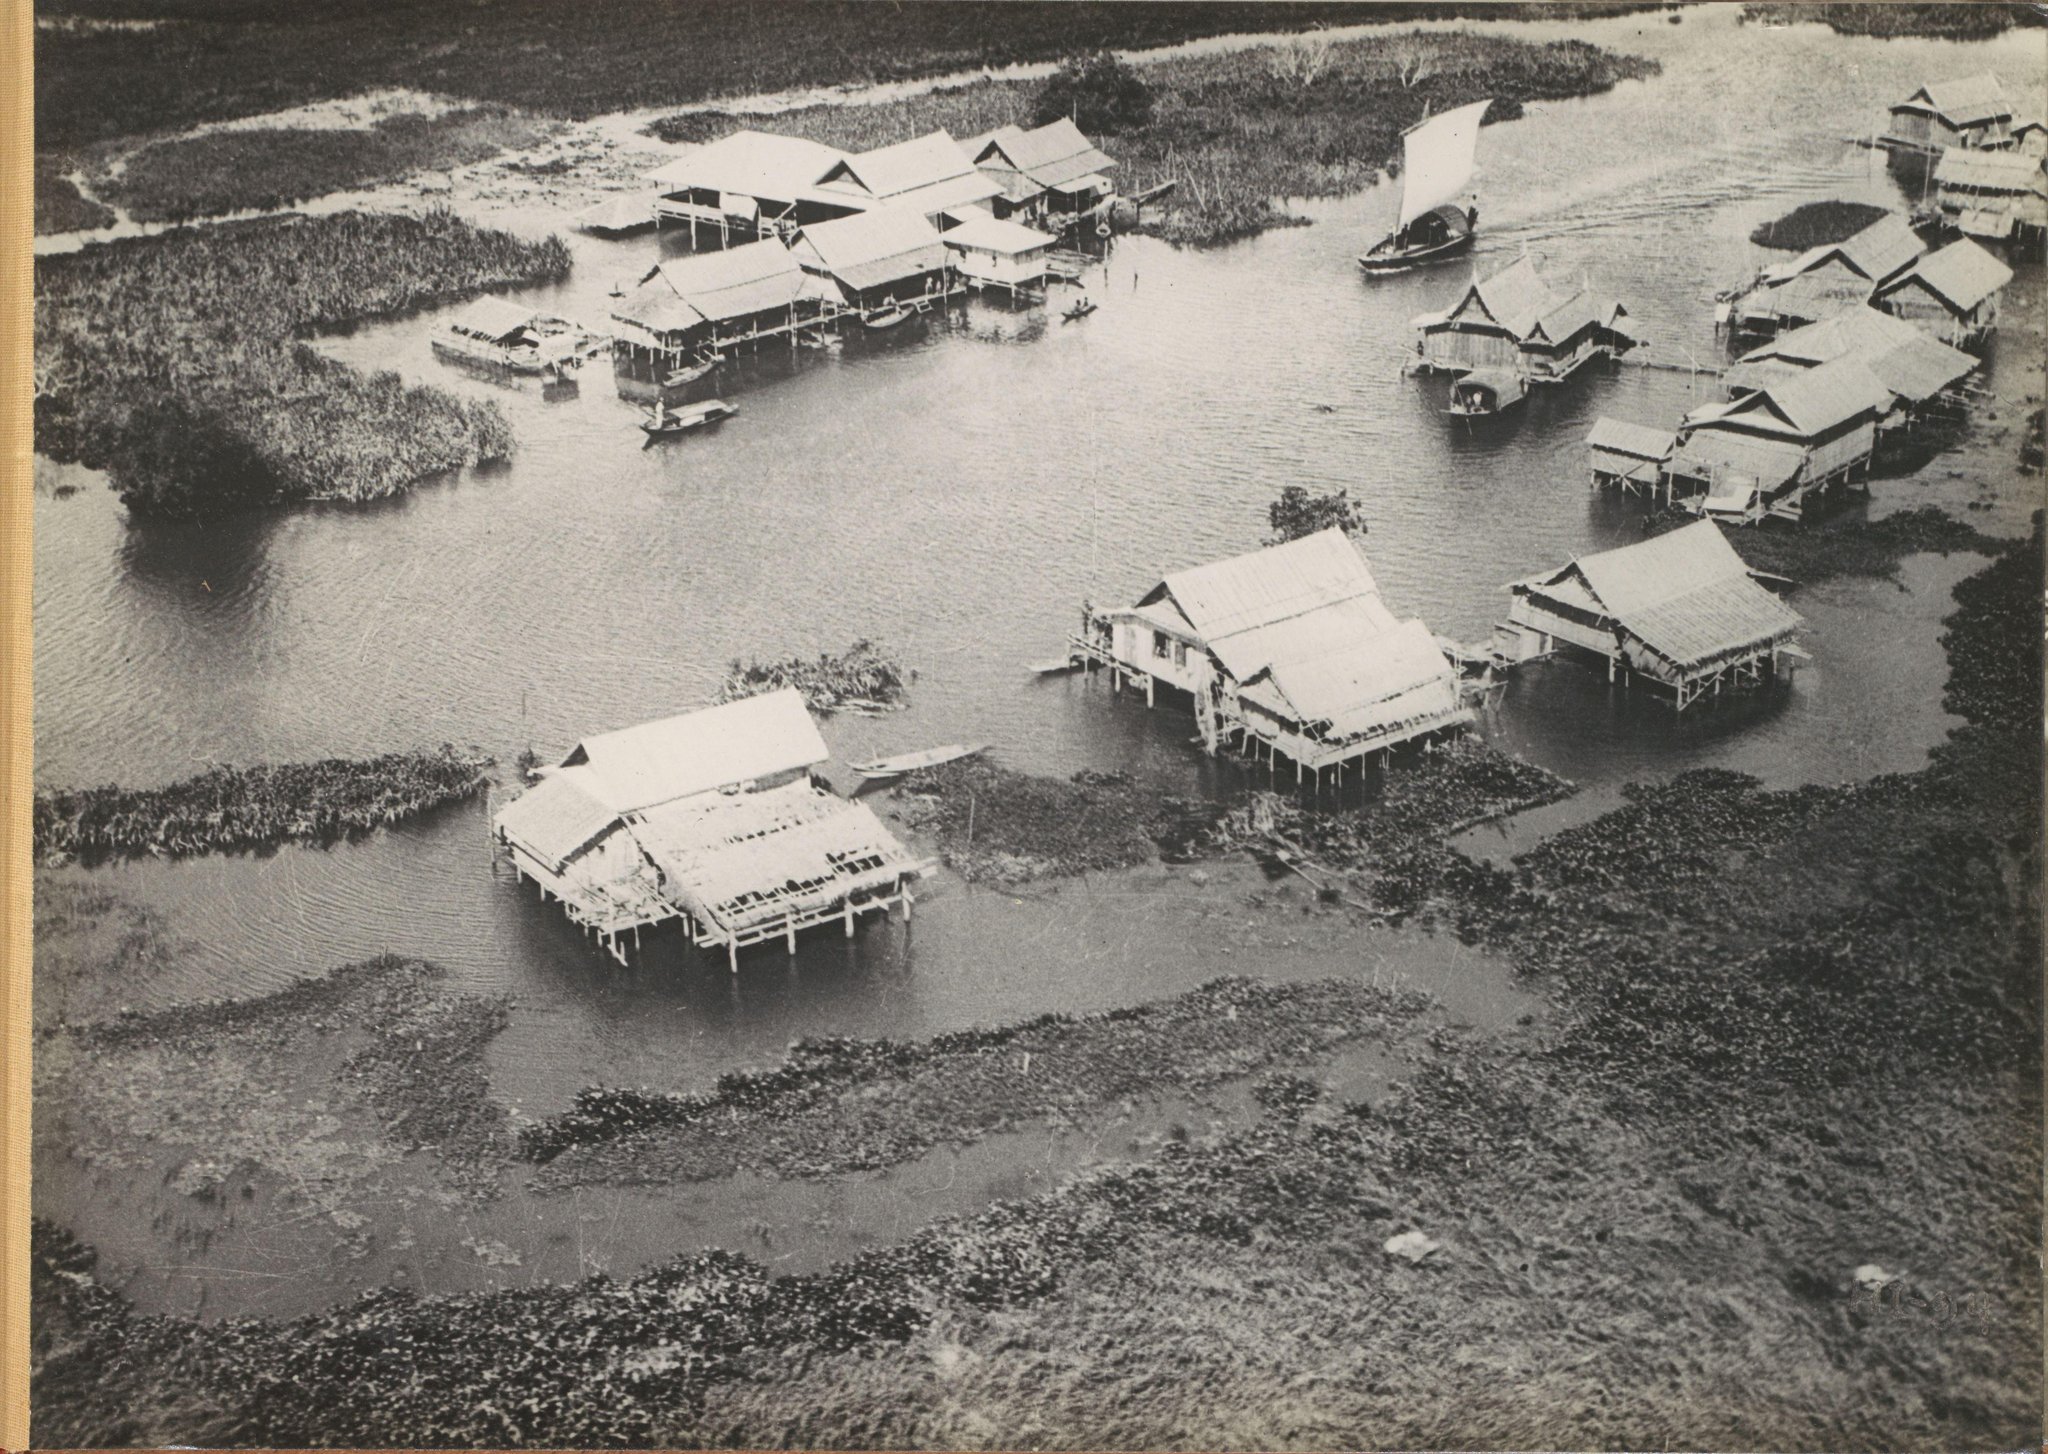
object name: album leaf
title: Paalwoningen in het water (vermoedelijk) in Nederlands-Indië, gezien vanuit de lucht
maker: Anonymous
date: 1930-1940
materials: cardboard, paper, photographic support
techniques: gelatin silver print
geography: dutch east indies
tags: airborne traffic, aviation, village, travelling; tourism, dutch east indies, the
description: Albumblad met een foto van een dorp met op palen staande huizen en een zeilboot. De opname is gemaakt op de vliegroute van de KLM-vlucht Amsterdam-Batavia. Onderdeel van Herdenkingsalbum van de Indië-lijn van de KLM, deel I.